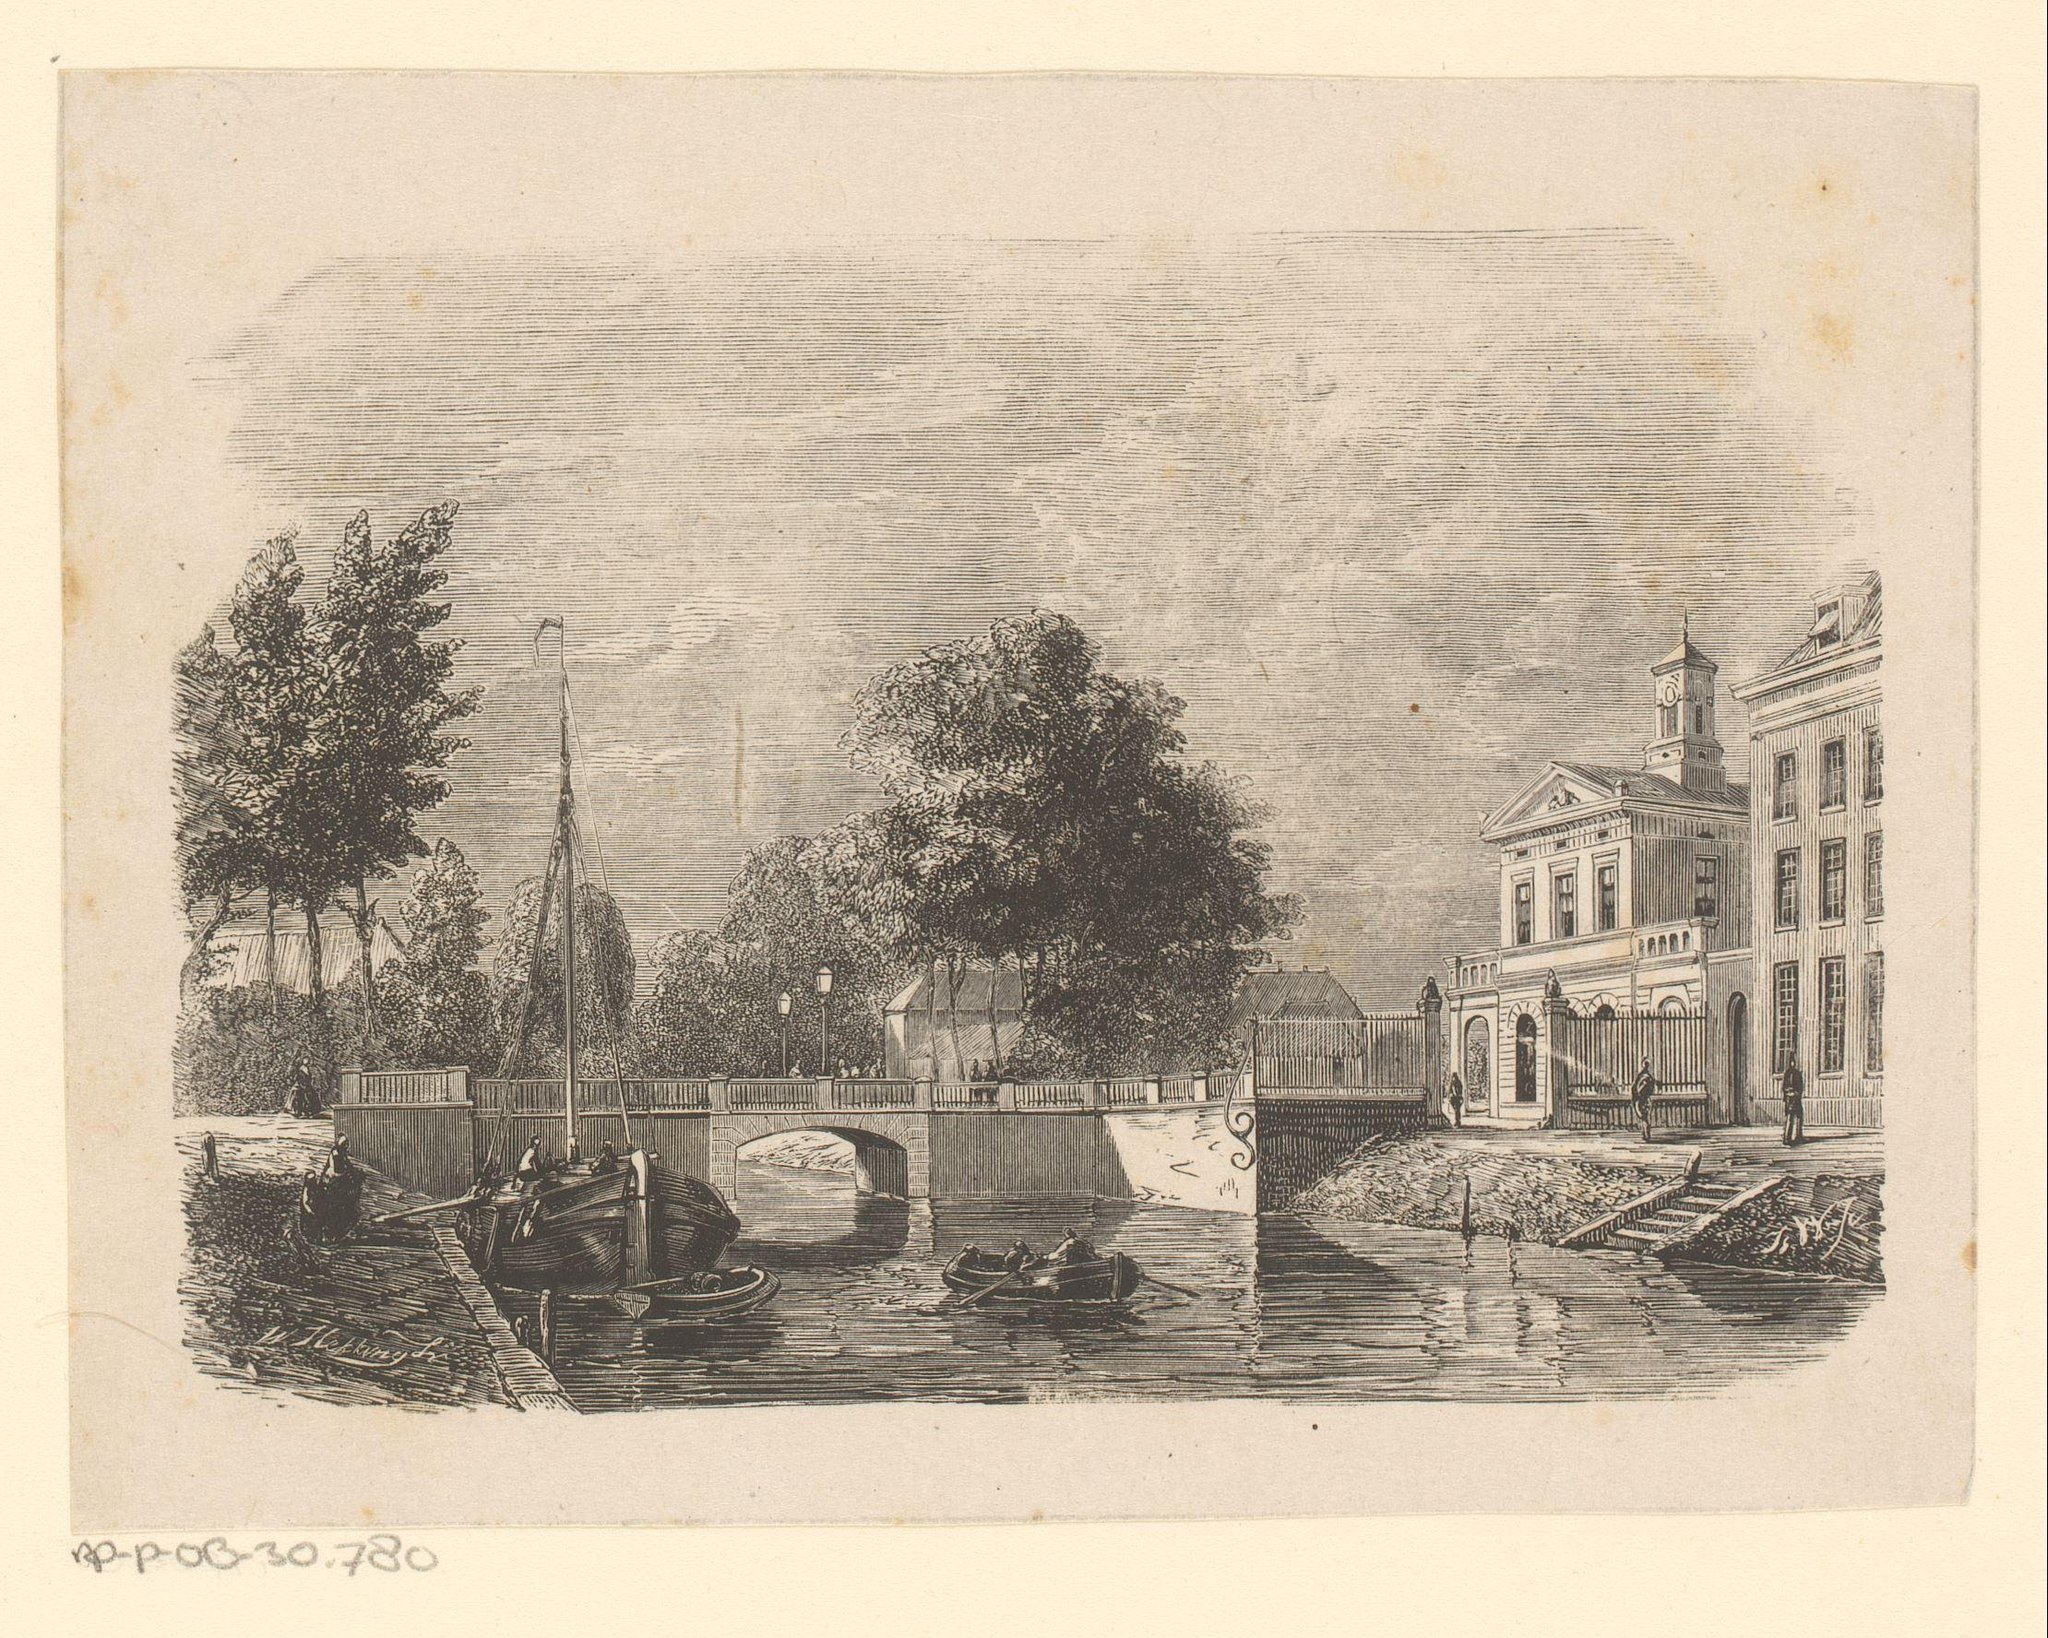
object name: print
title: Stadsgezicht met een brug en twee schepen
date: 1836-1912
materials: paper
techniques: engraving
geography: netherlands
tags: bridge in city across river, canal, etc. (+ city(-scape) with figures, staffage), ships (in general)